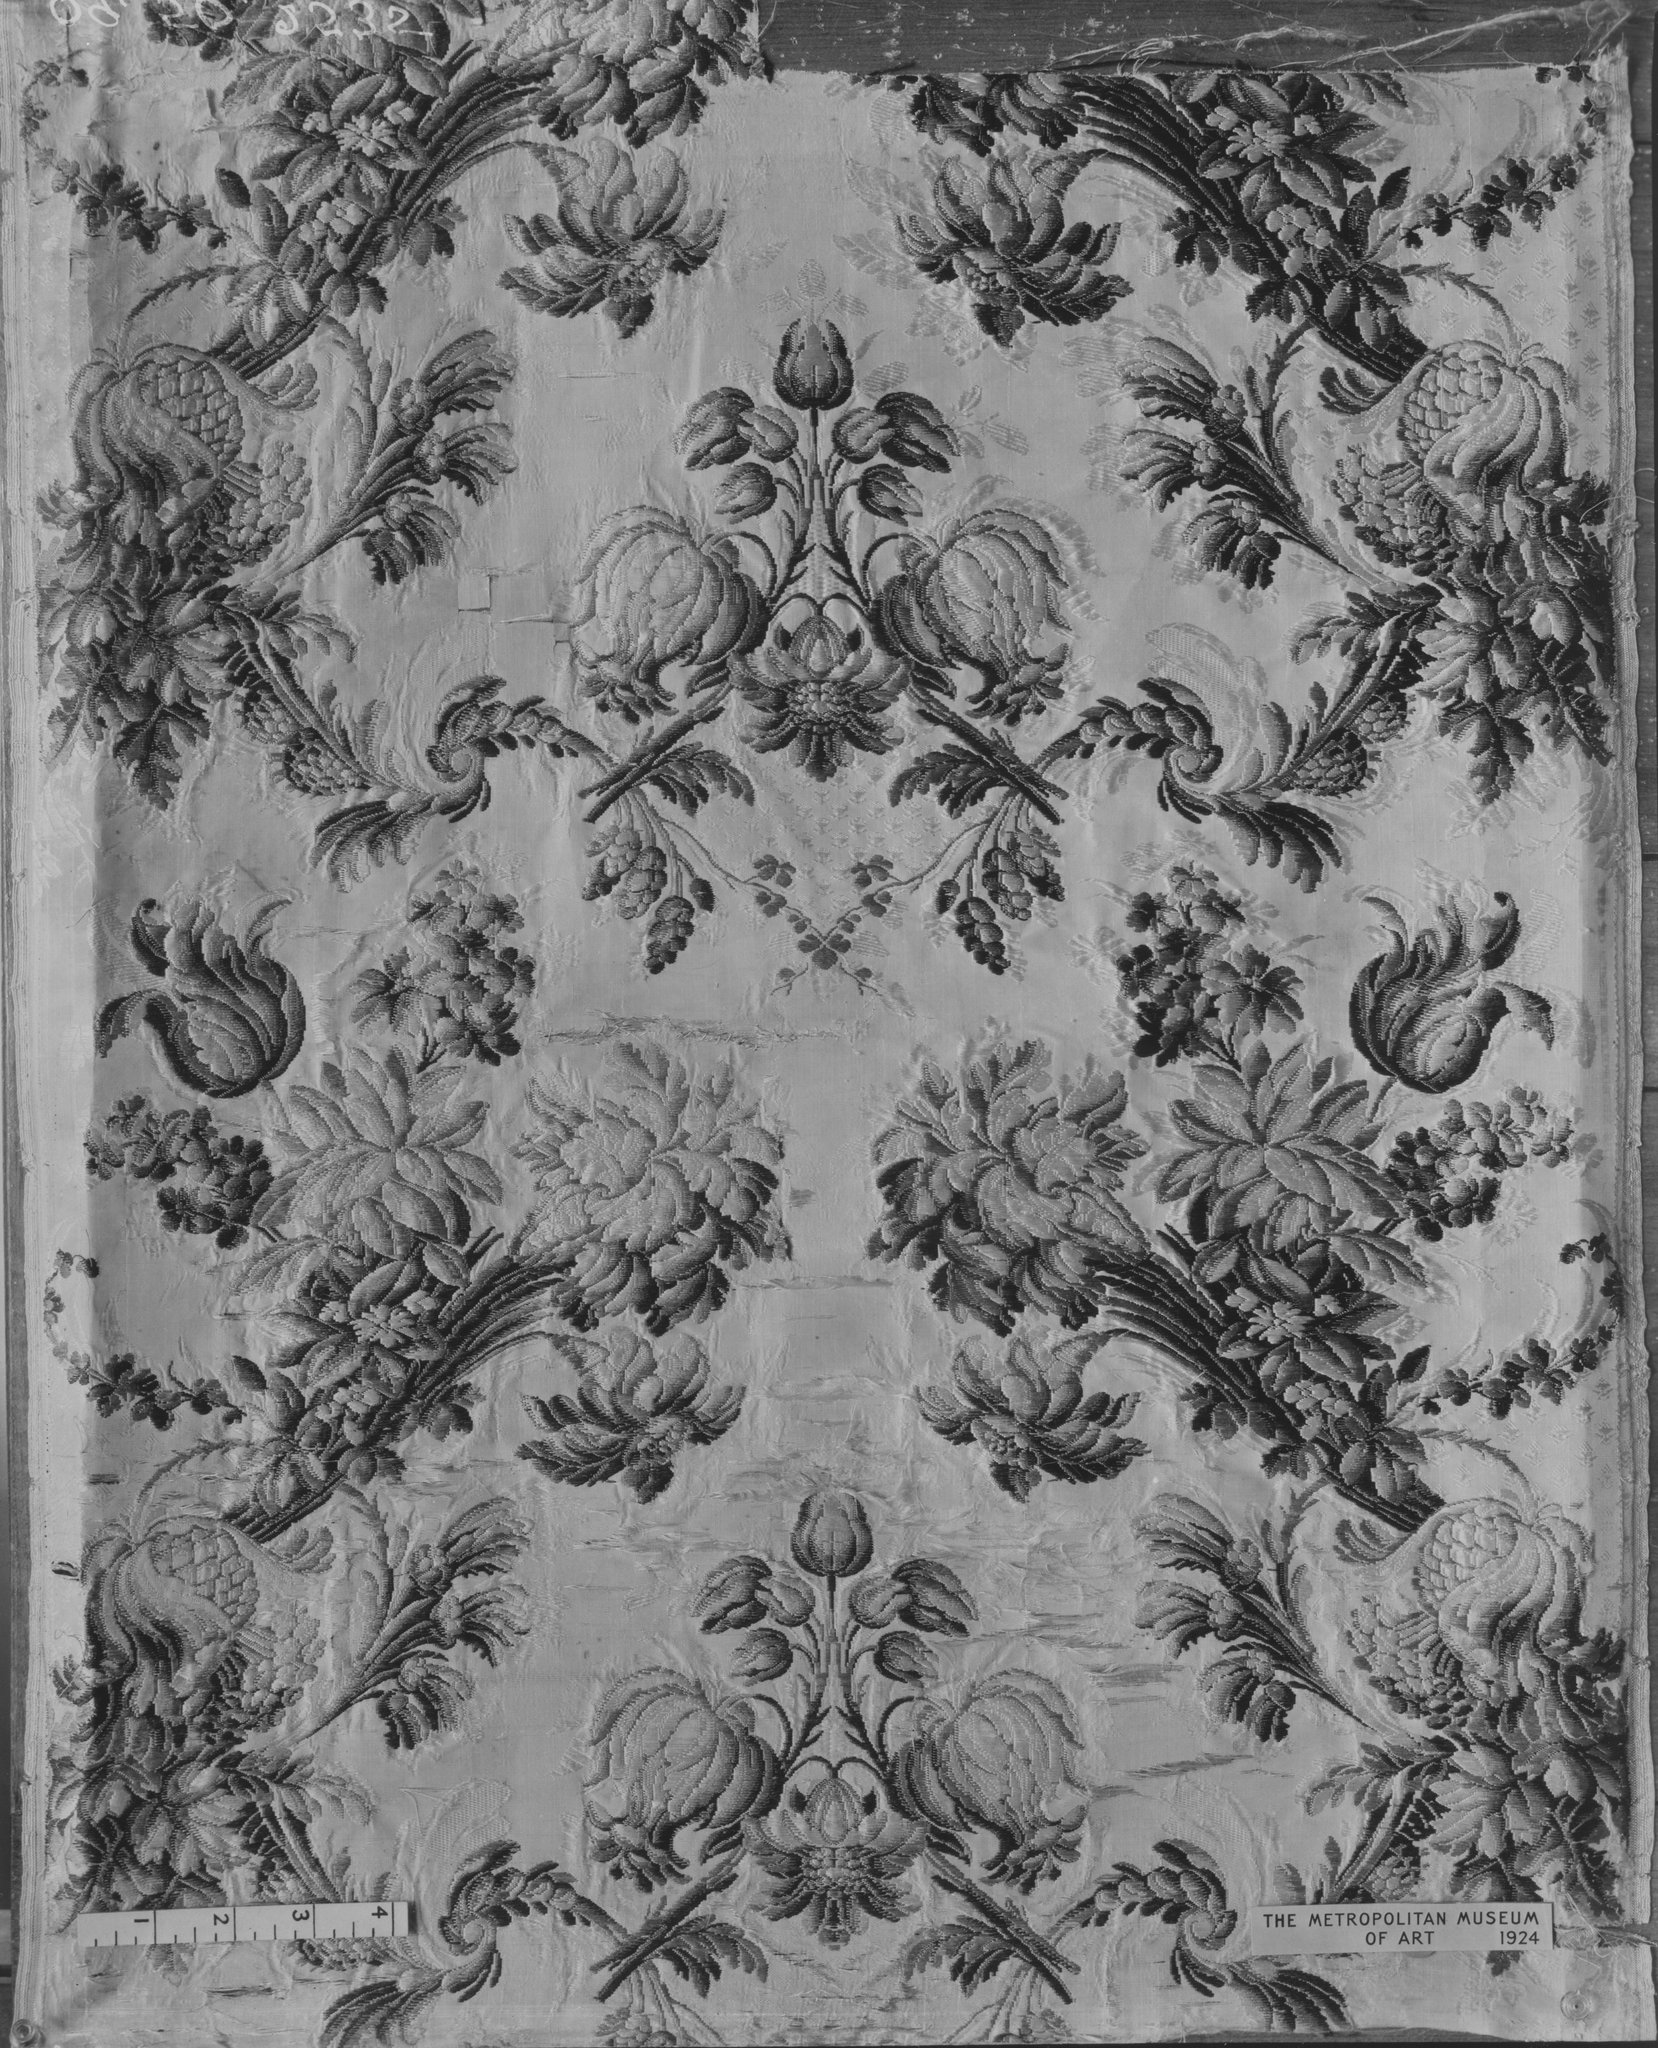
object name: piece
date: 1740-1750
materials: silk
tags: flowers,leaves